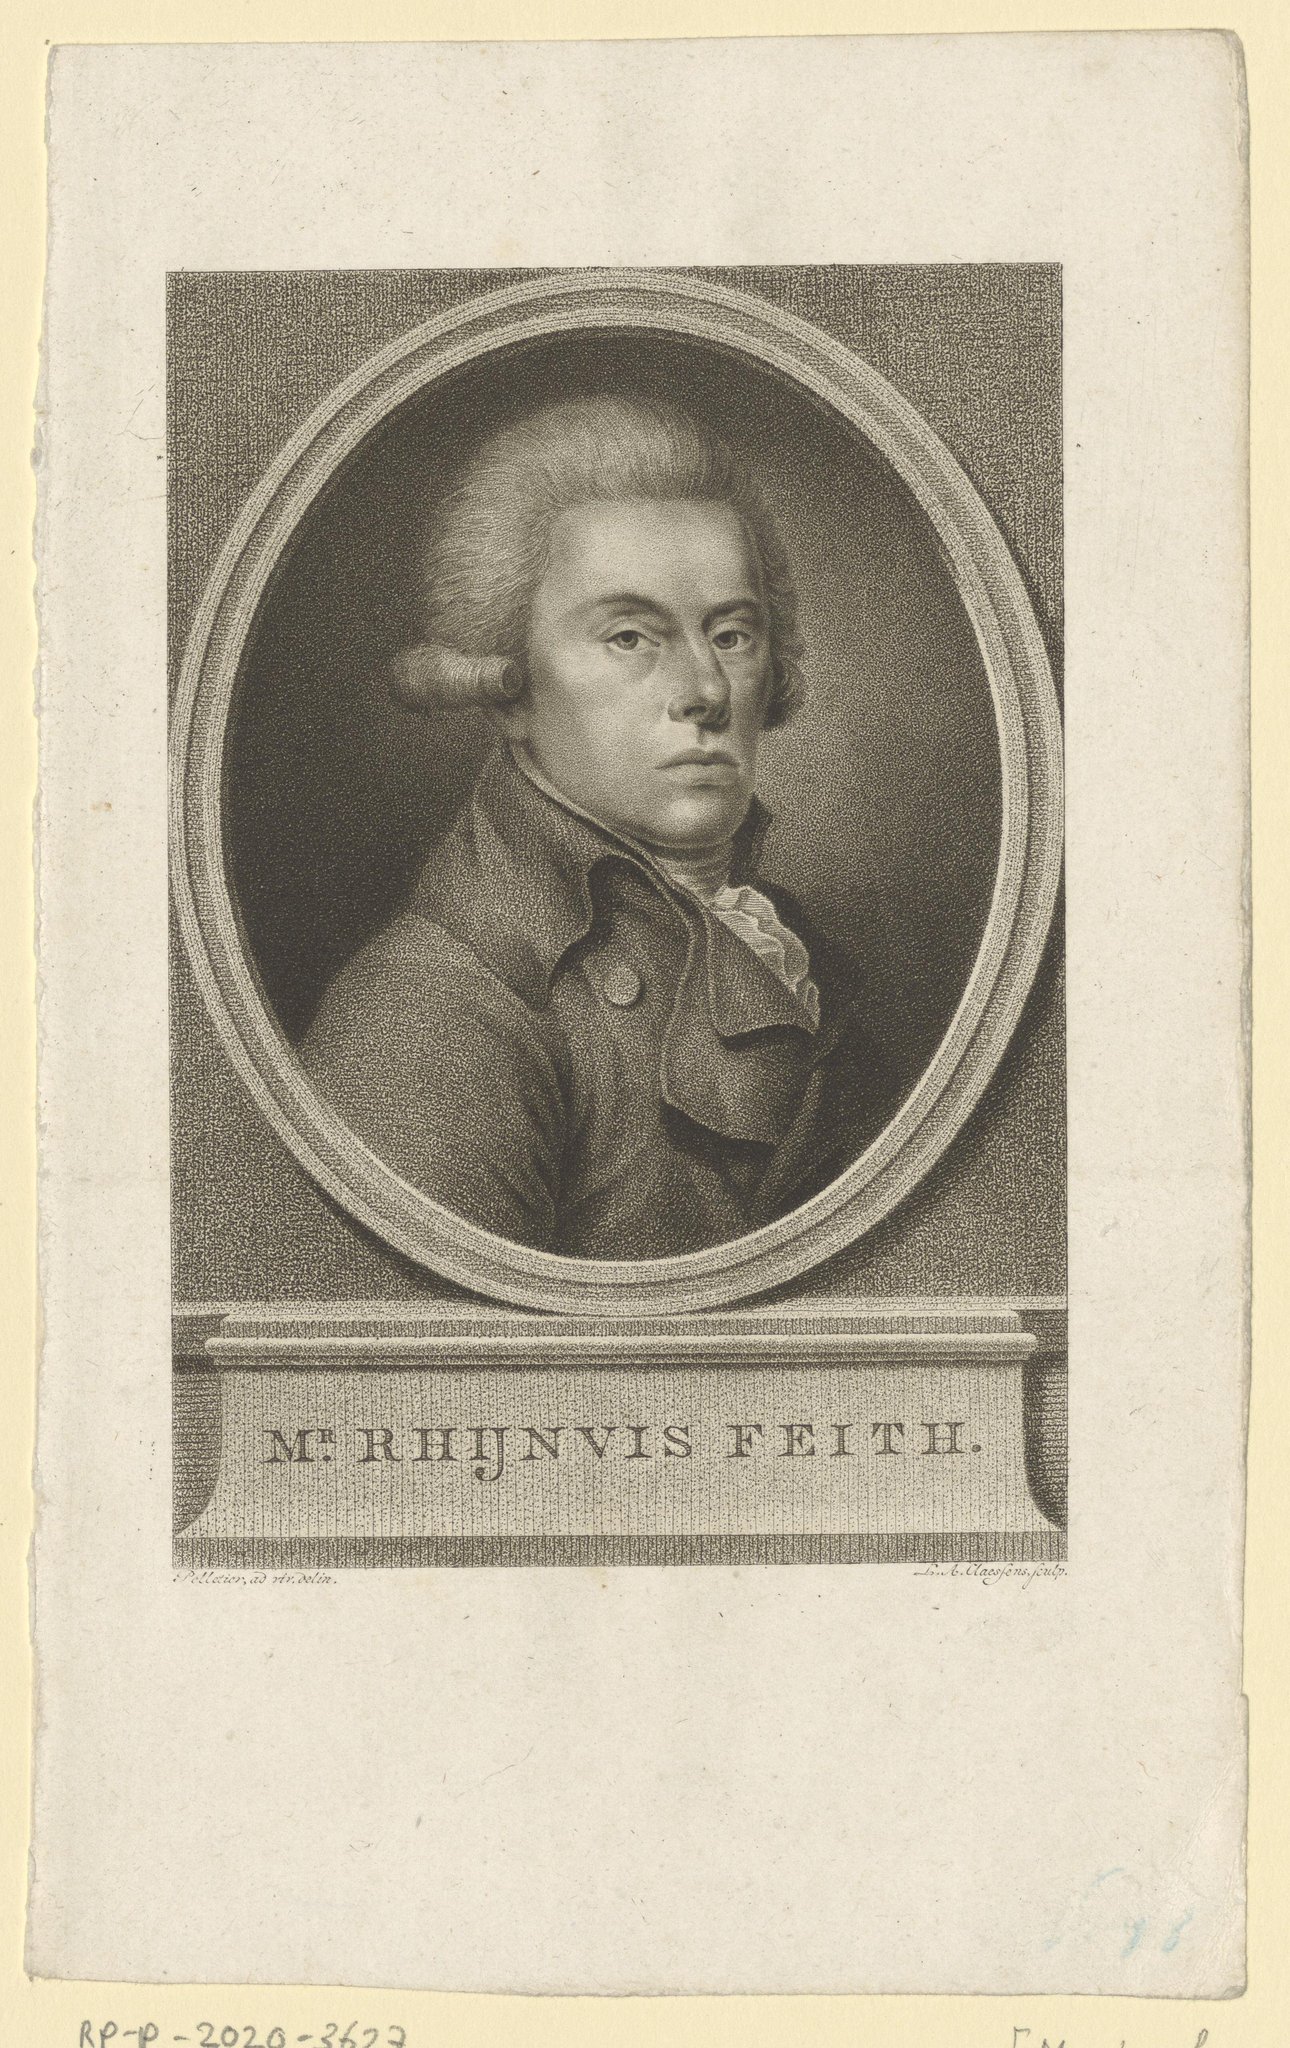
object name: print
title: Portret van Rhijnvis Feith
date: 1795-1808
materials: paper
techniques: engraving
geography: amsterdam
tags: rhijnvis feith, historical persons, portrait of a writer